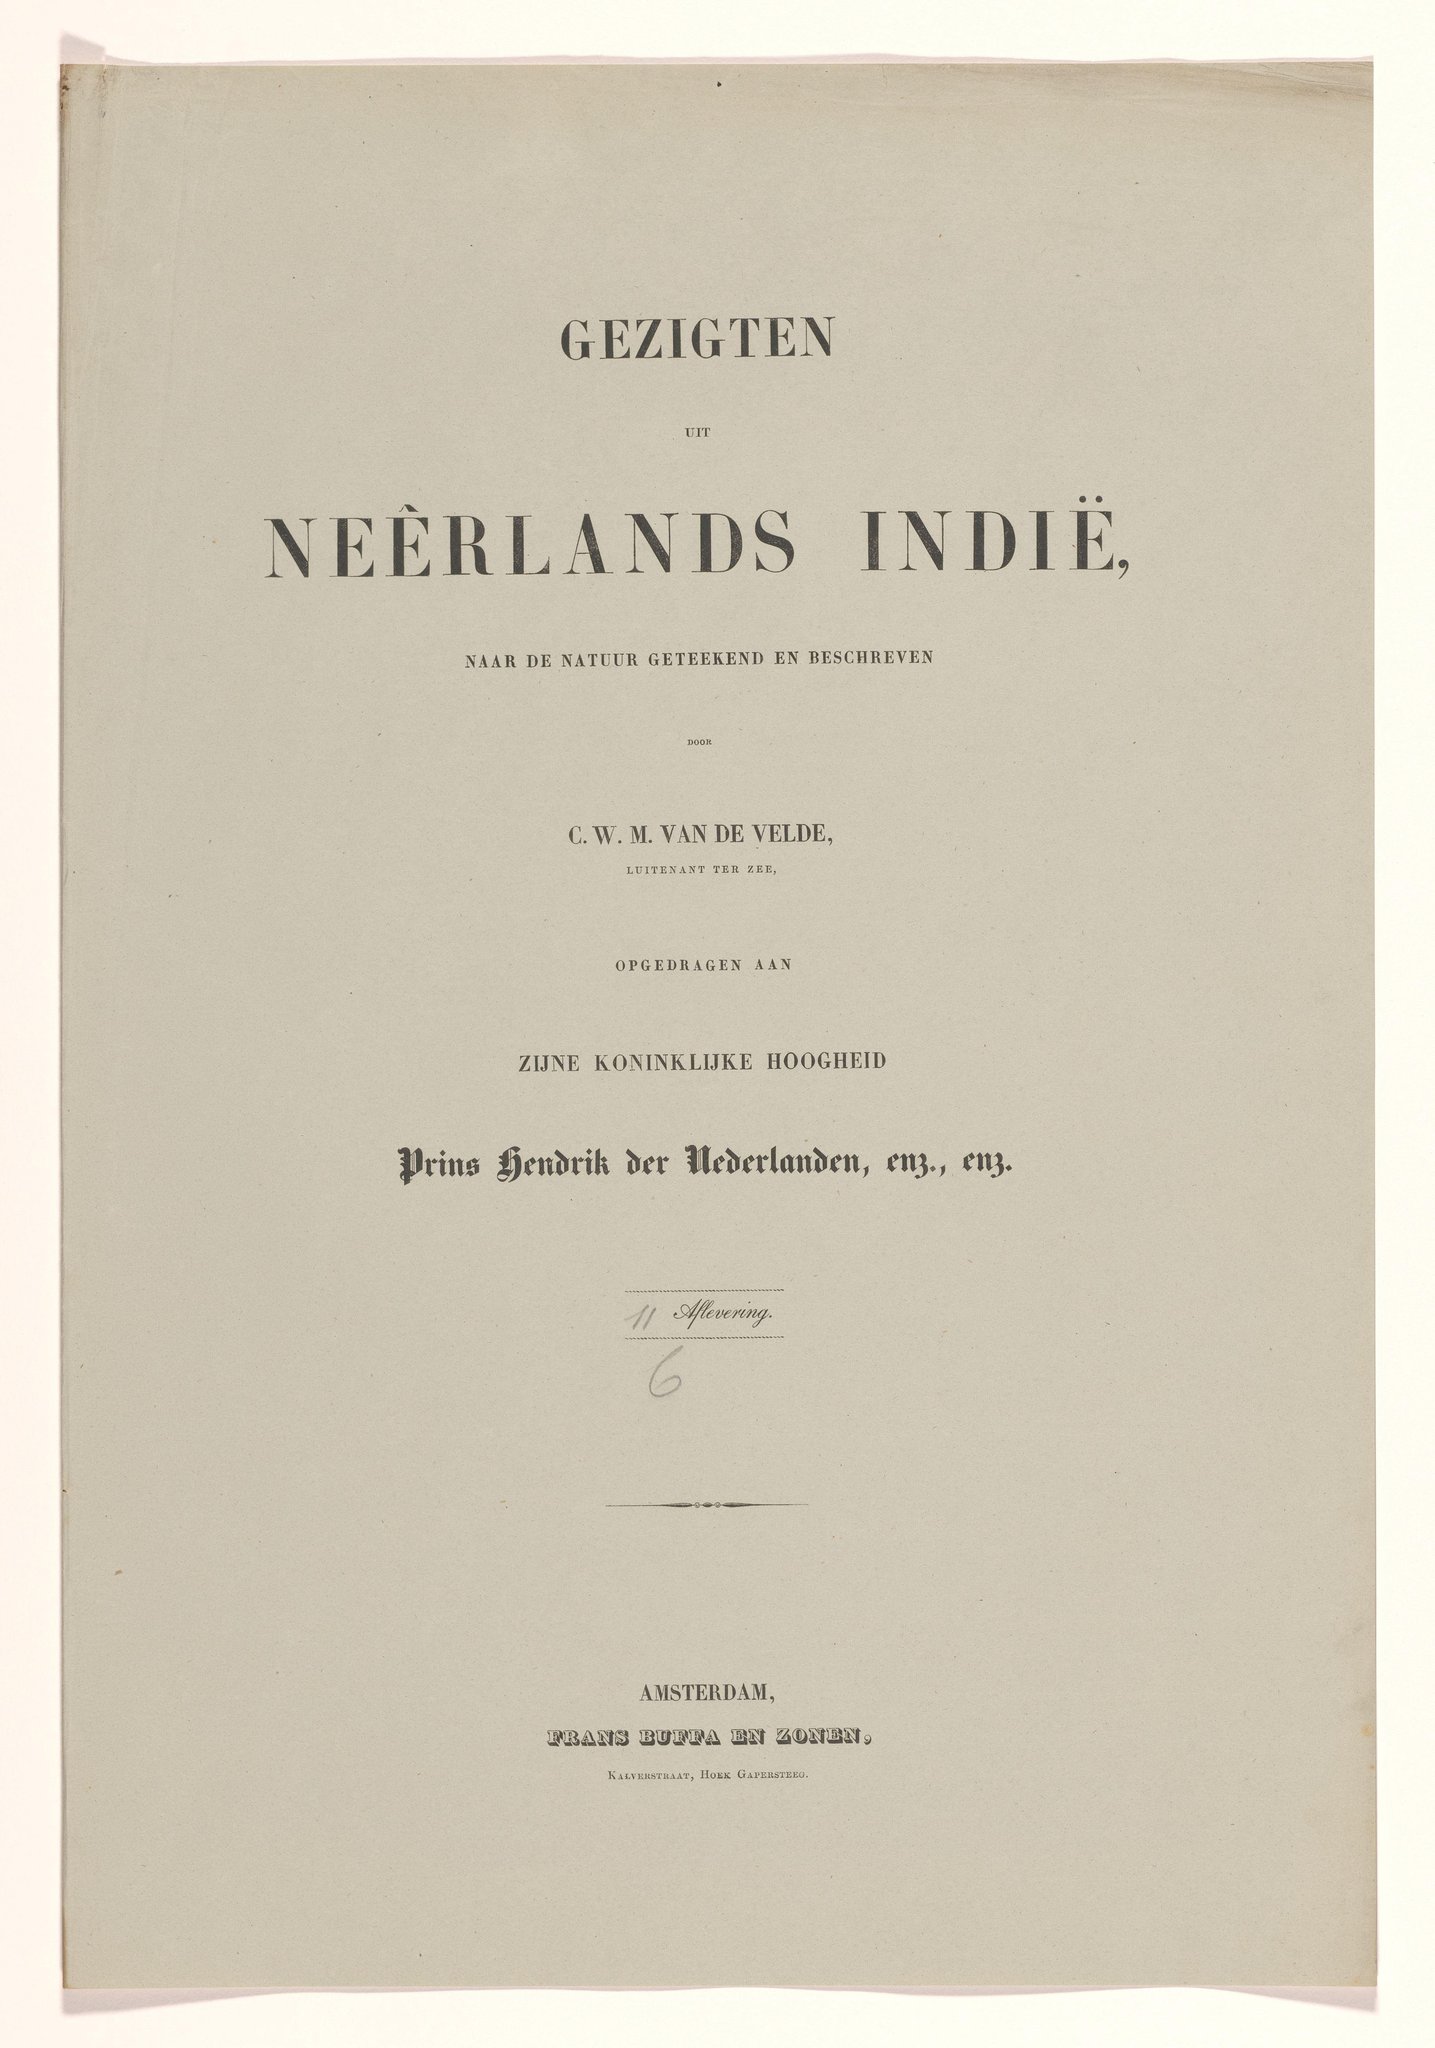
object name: print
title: Gezigten uit Neêrlands Indië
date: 1843-1845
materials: paper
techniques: lithograph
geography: brussels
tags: landscapes in the non-temperate zone, exotic landscapes, dutch east indies, the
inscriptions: inscription: ‘11 C’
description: Omslag met zeven losse bladen waaronder drie tekstbladen en vier lithografieën. De omslag maakt deel uit van een map met twaalf omslagen.